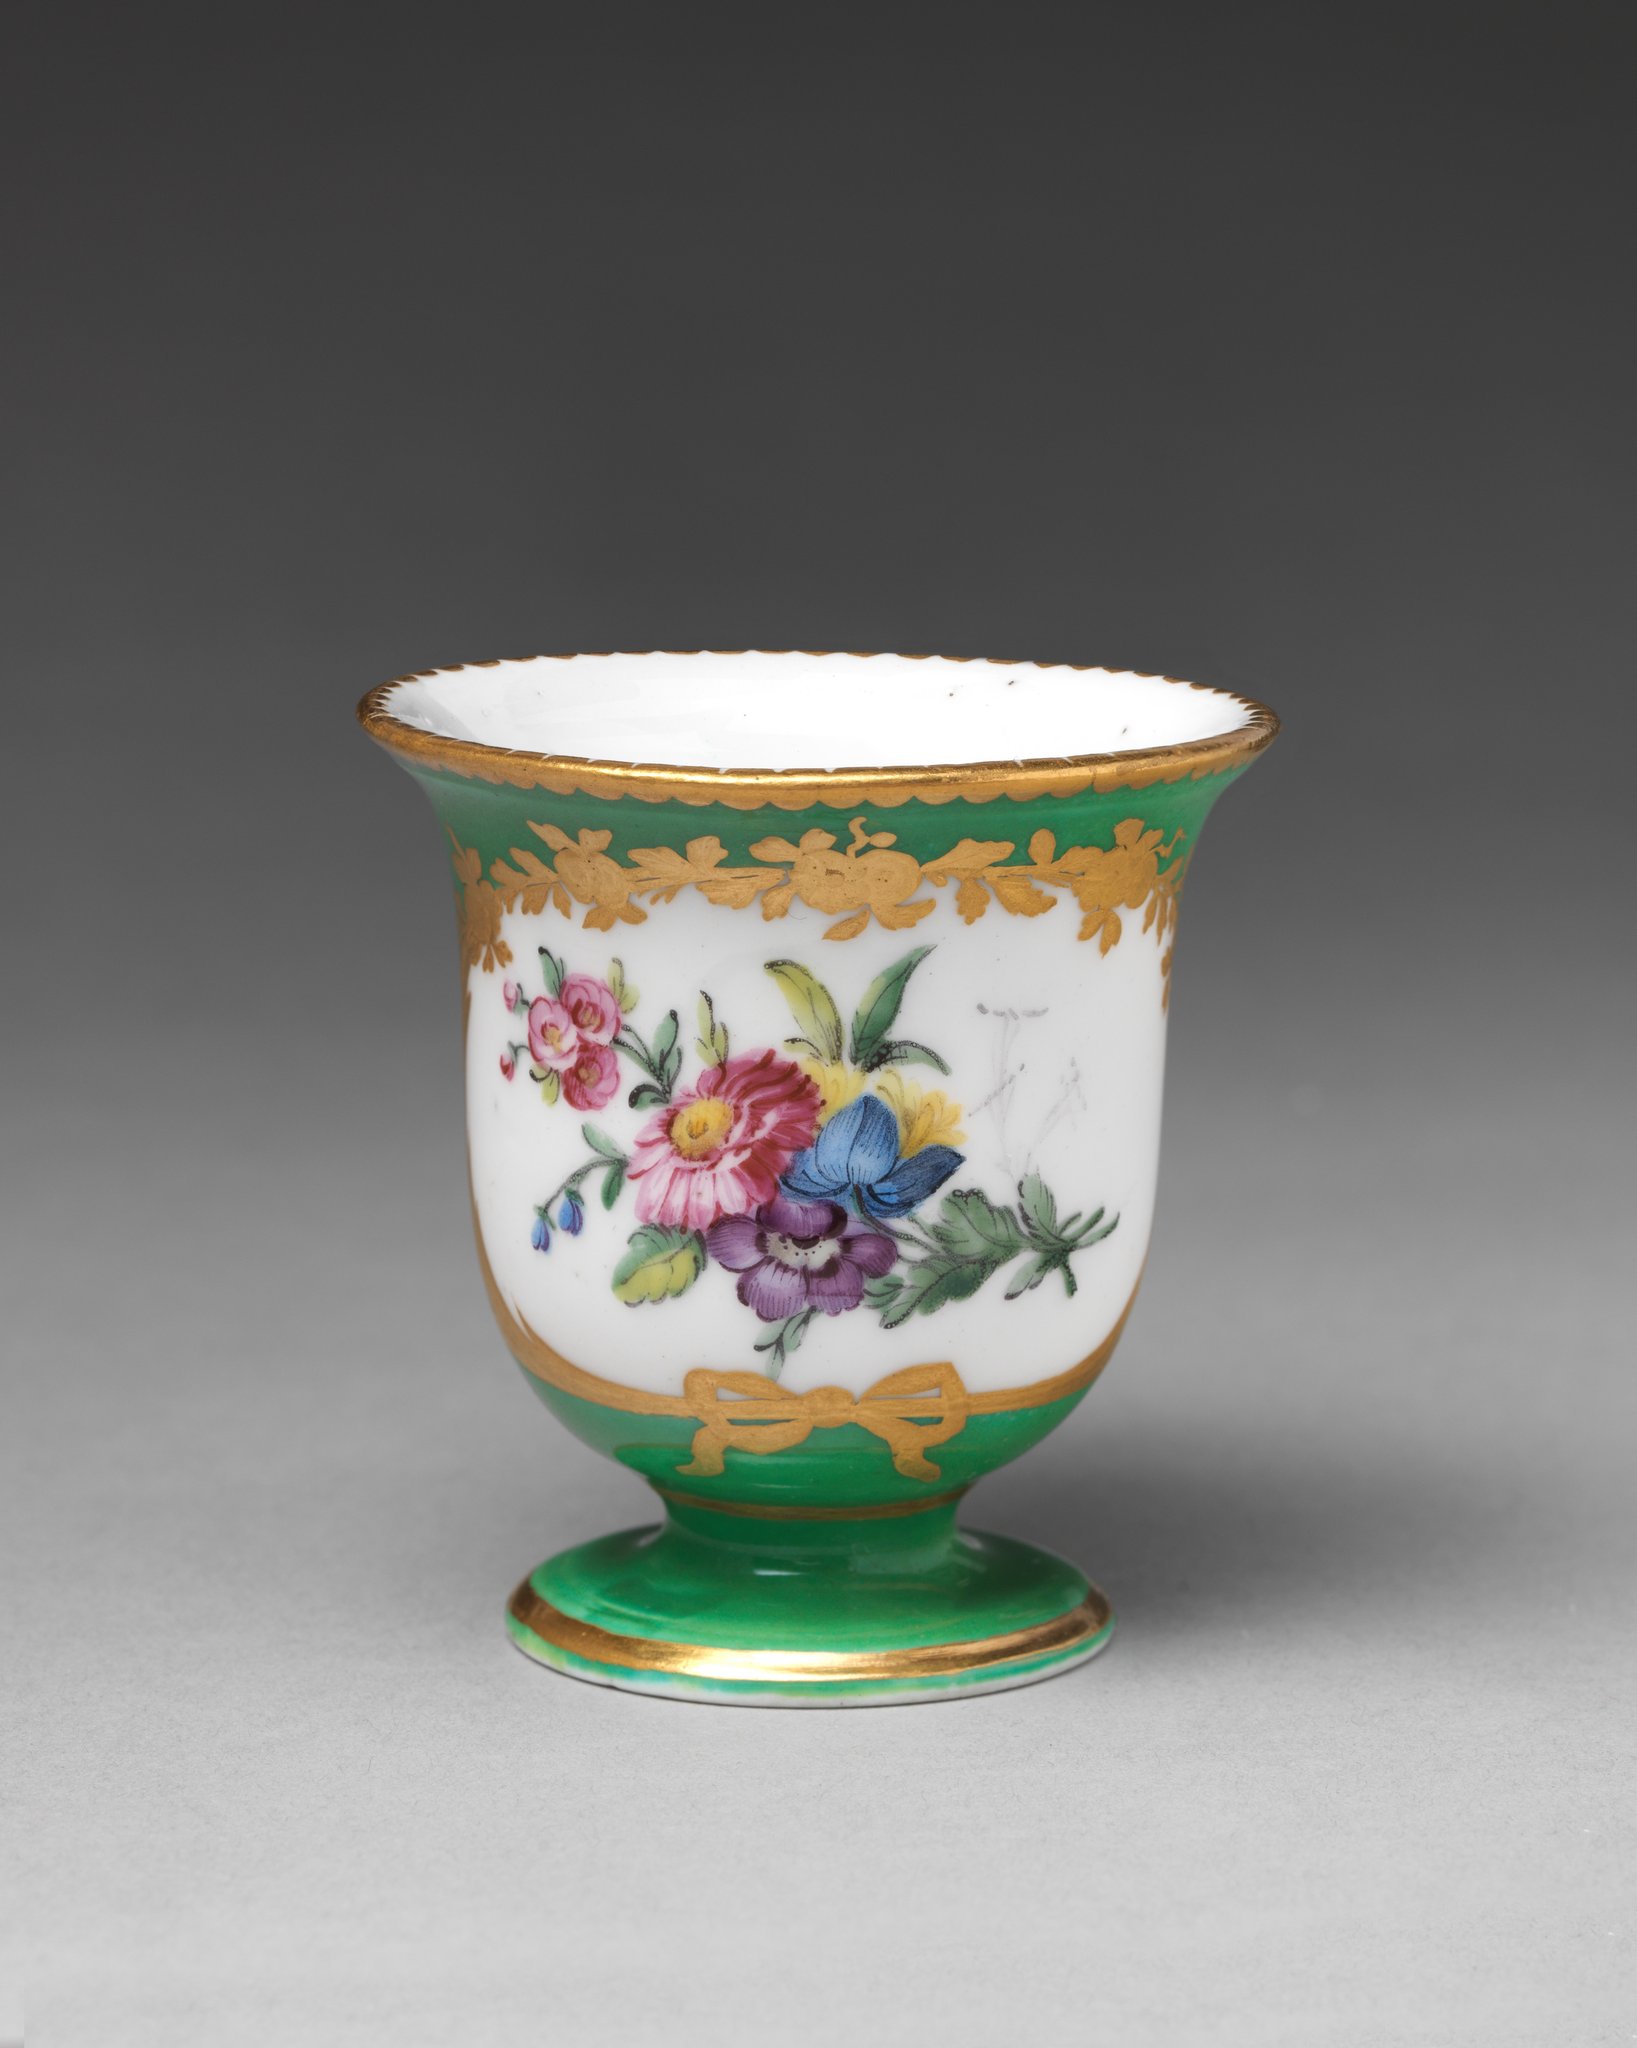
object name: ice cream cup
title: Ice cream cup (Tasse à glace) (part of a service)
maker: sèvres manufactory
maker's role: manufactory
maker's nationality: french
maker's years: 1740-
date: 1780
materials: soft paste porcelain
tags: flowers